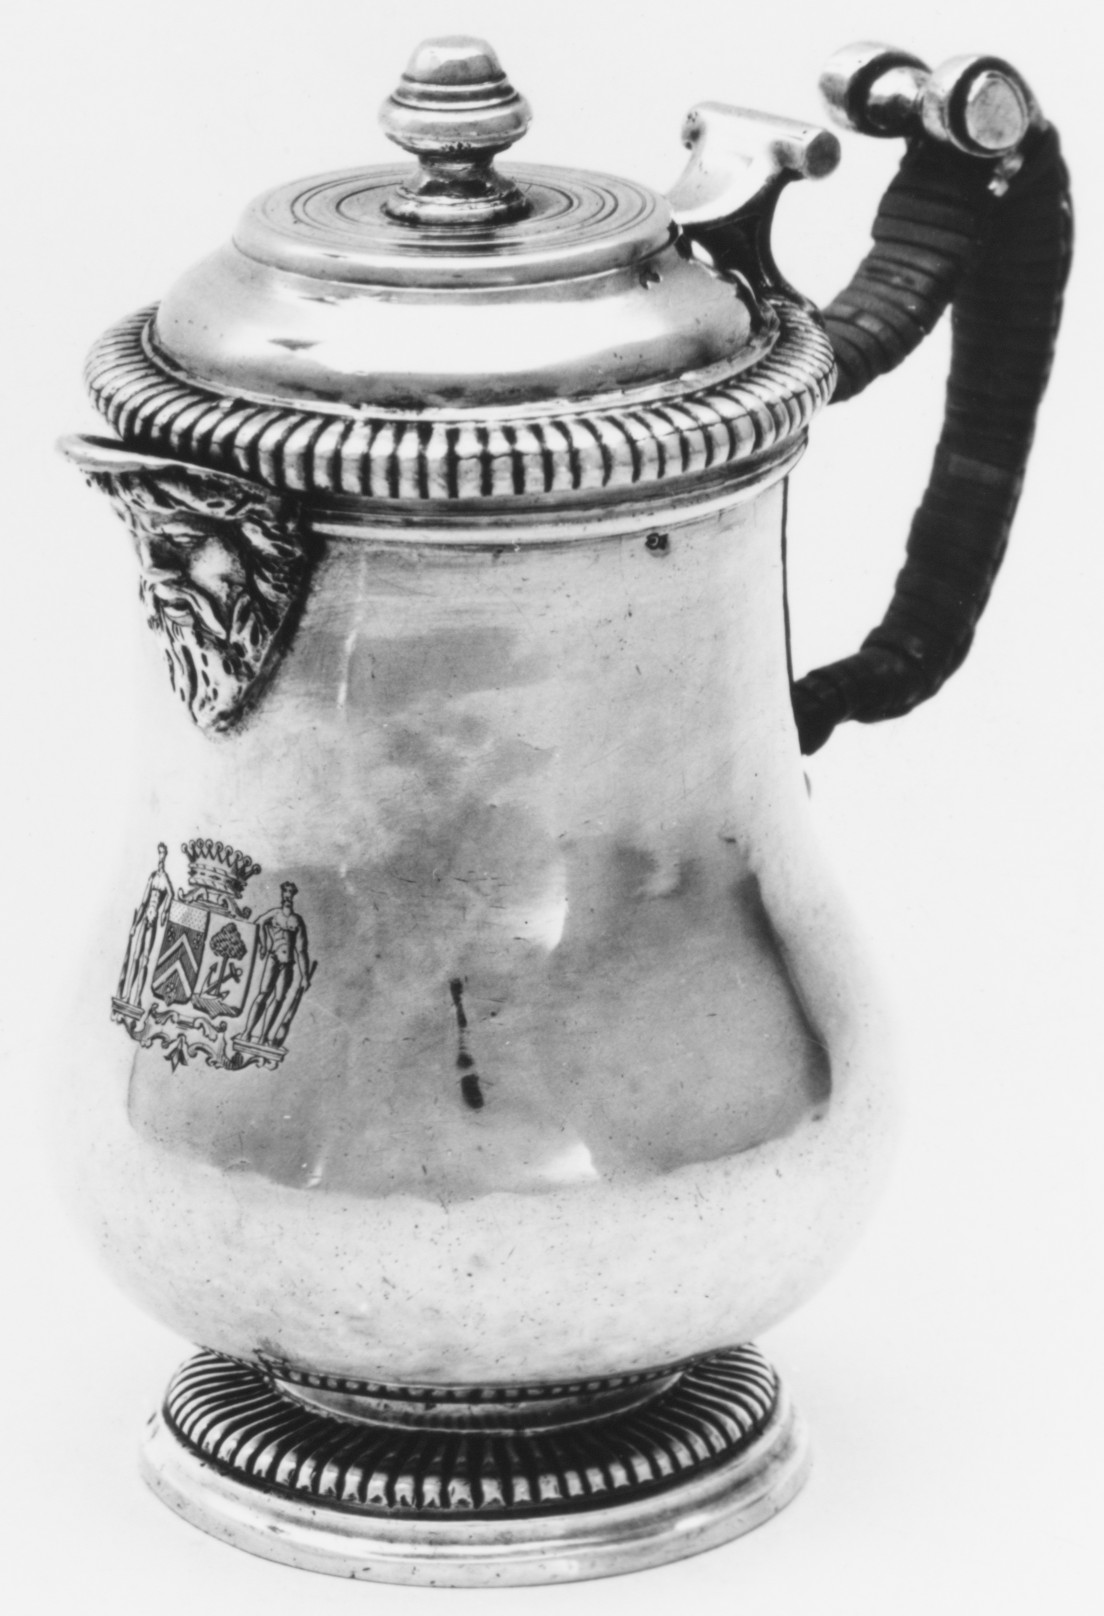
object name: mustard pot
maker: christophe troy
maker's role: maker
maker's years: 1712-1767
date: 1739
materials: silver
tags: faces,coat of arms